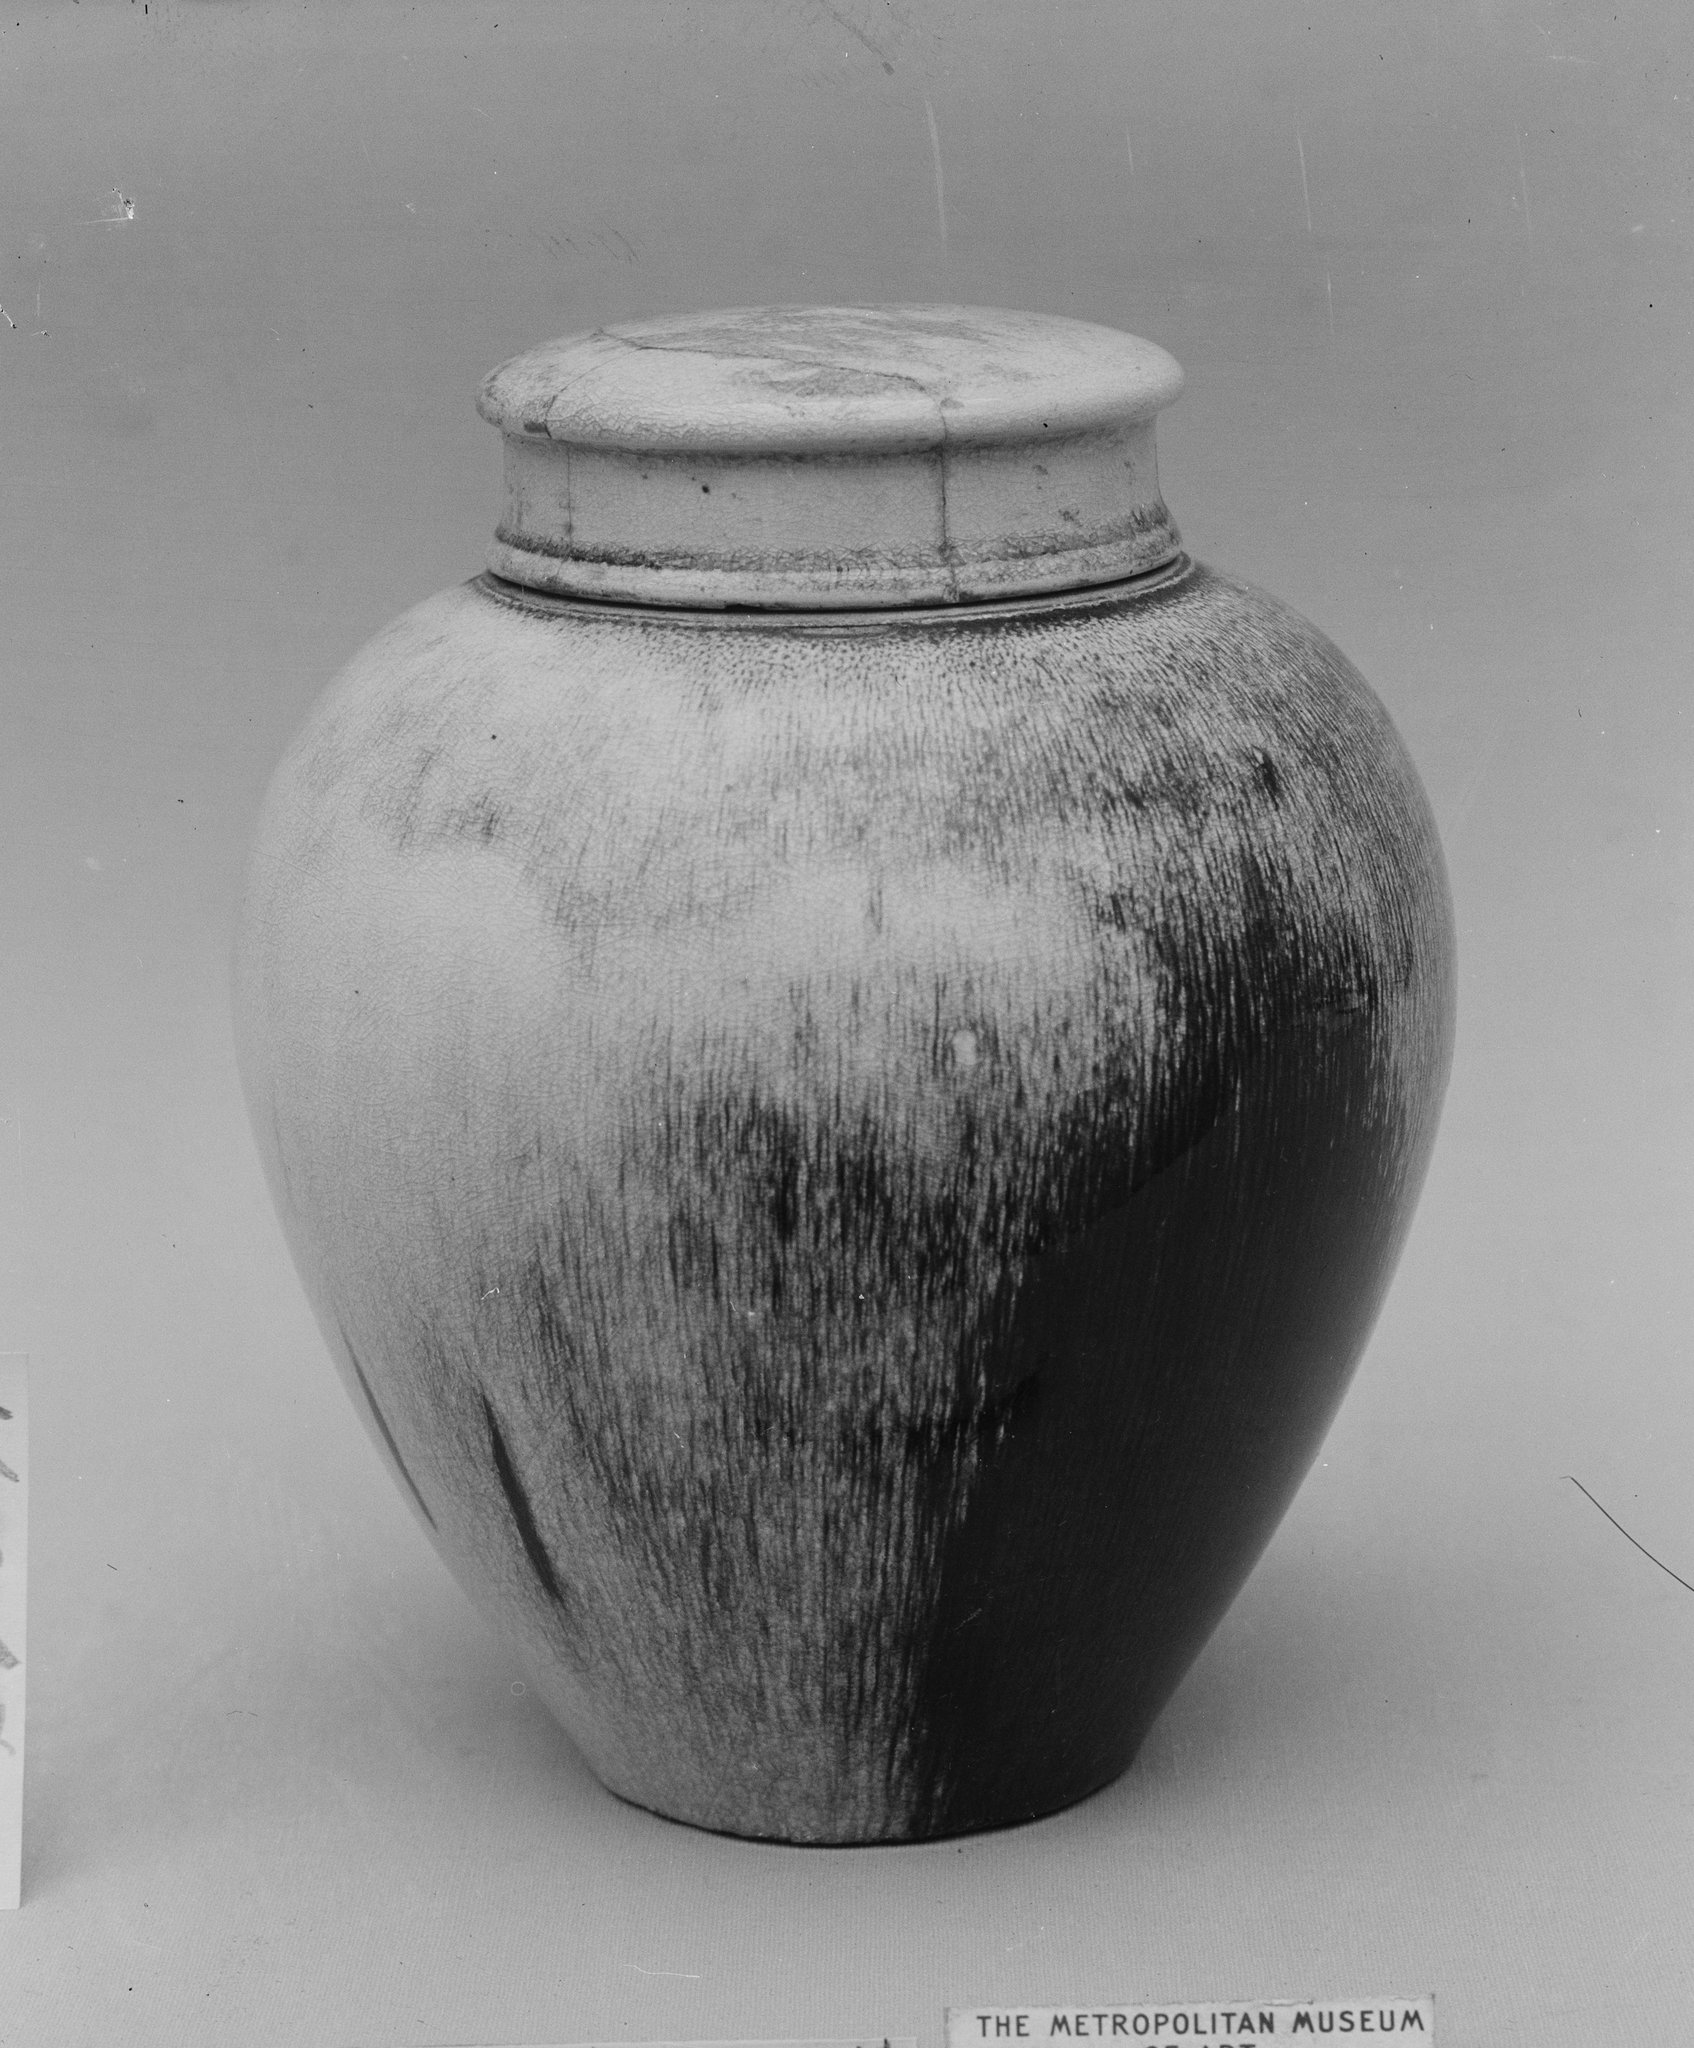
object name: jar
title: Jar with Double Cover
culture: japanese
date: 1680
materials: clay, glaze